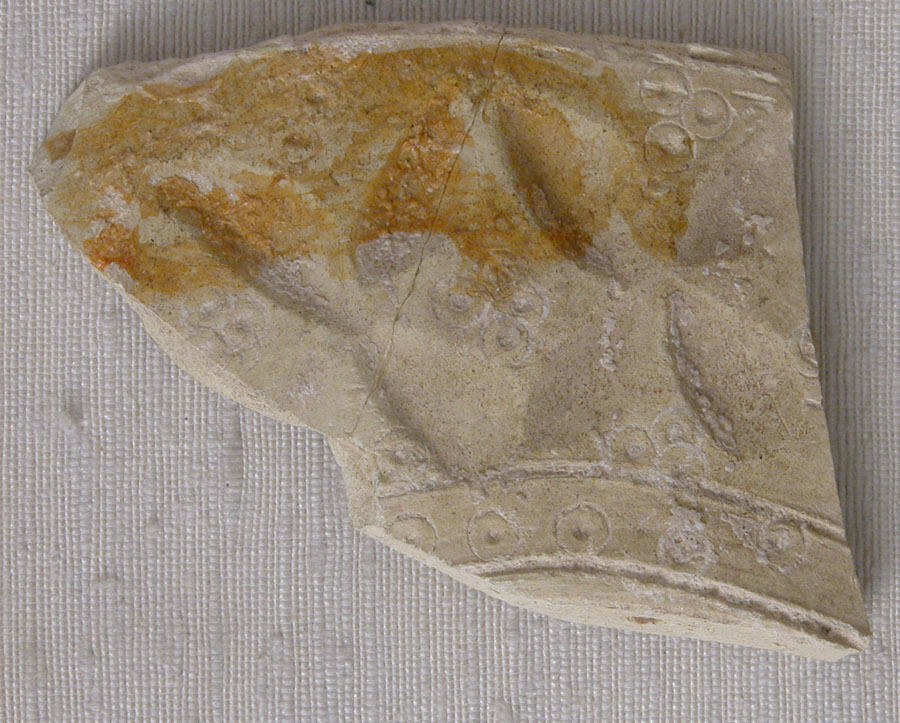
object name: fragment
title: Ceramic Fragment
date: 801-1000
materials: earthenware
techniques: incising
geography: saudi arabia